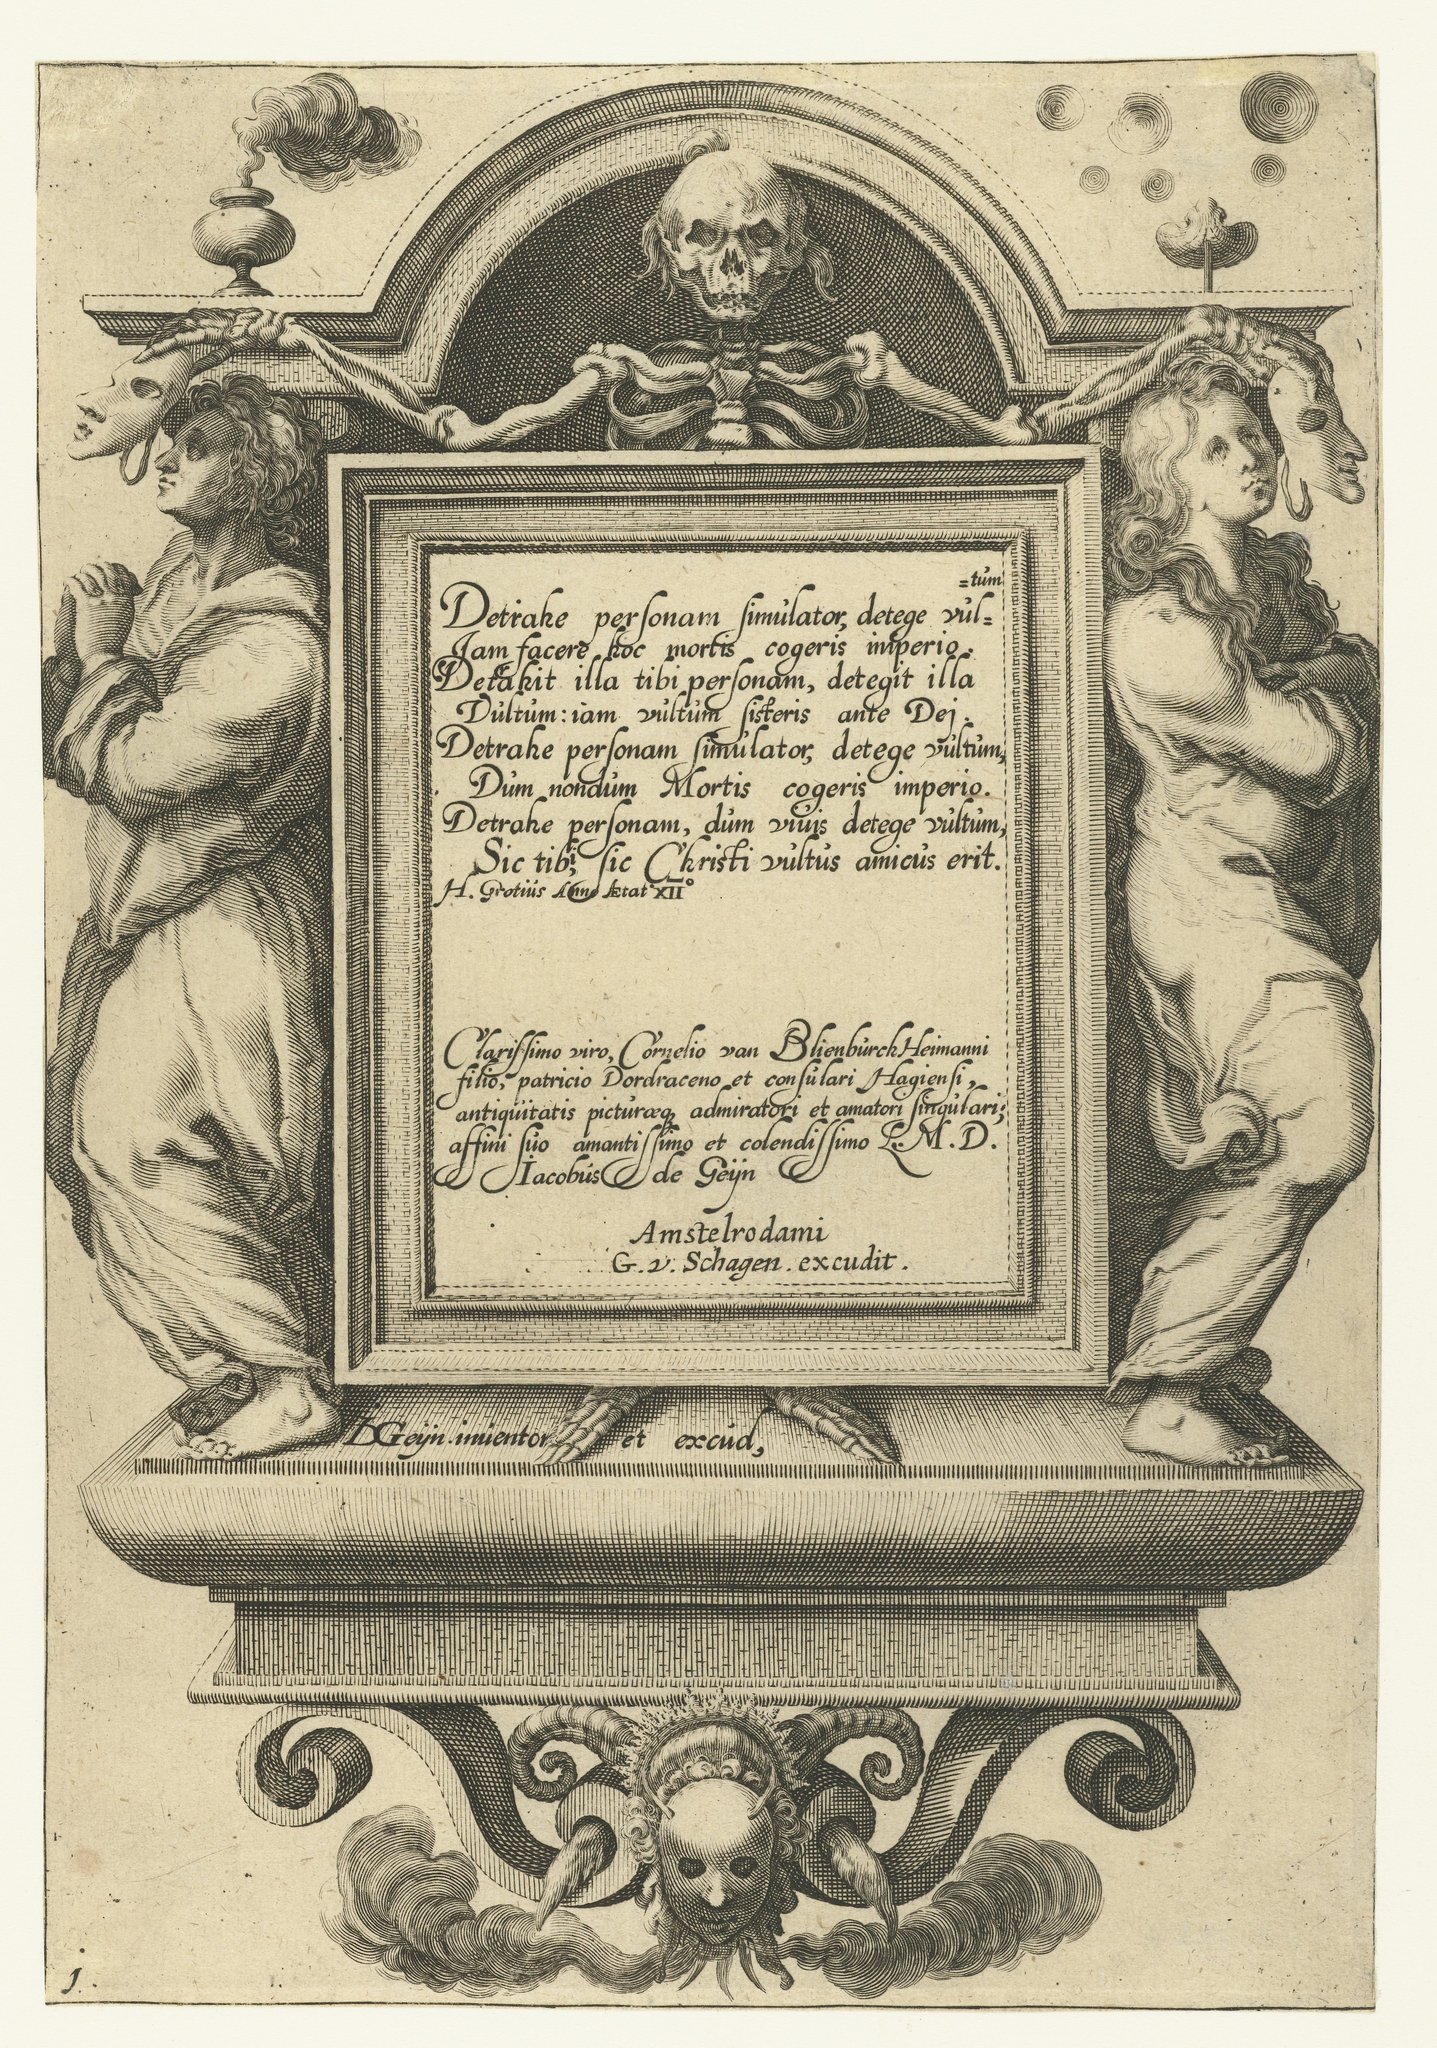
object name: print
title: De maskerades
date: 1595-1596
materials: paper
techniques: engraving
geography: leiden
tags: mask, death as skeleton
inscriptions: collector's mark: Lugt 2228a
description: Een Latijnse tekst in een cartouche, waarboven een skelet uitkomt. Dit skelet houdt een masker voor de gezichten van de twee figuren die tegen de linker- en de rechterzijde van de cartouche geleund staan. Deze prent is onderdeel van een serie van tien genummerde prenten: een titelprent en negen prenten waarop twee of drie gemaskerde en/of verklede figuren ten voeten uit zijn weergegeven.